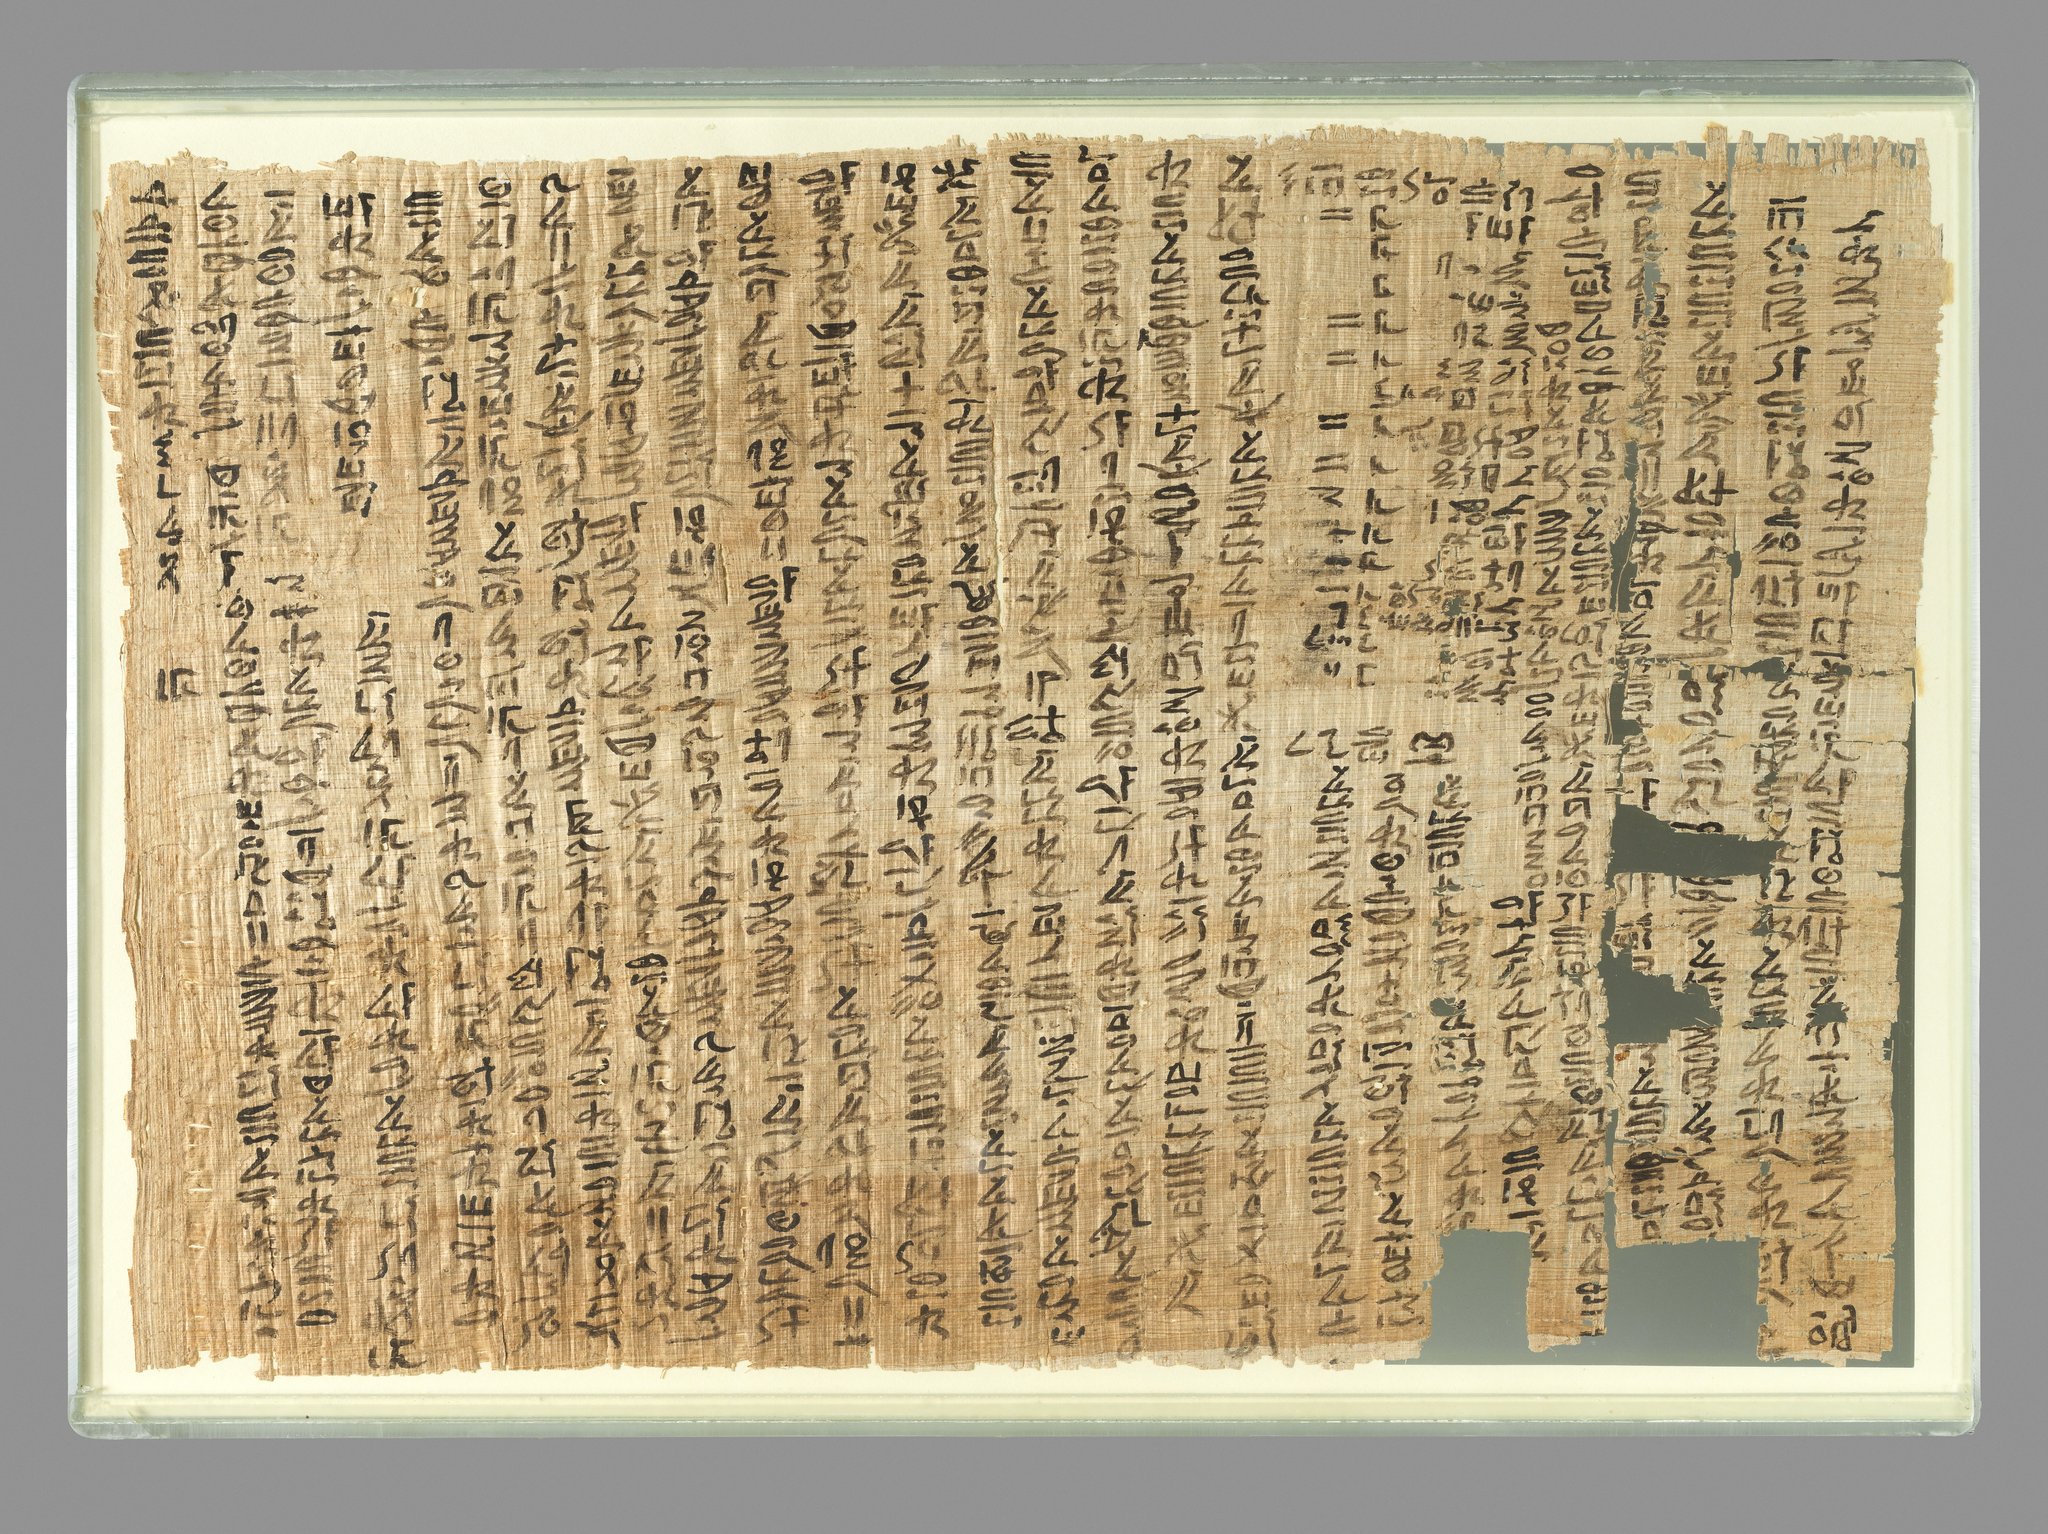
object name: papyrus, letter, heqanakht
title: Heqanahkt Letter II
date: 1961-1917 BCE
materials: ink, papyrus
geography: egypt